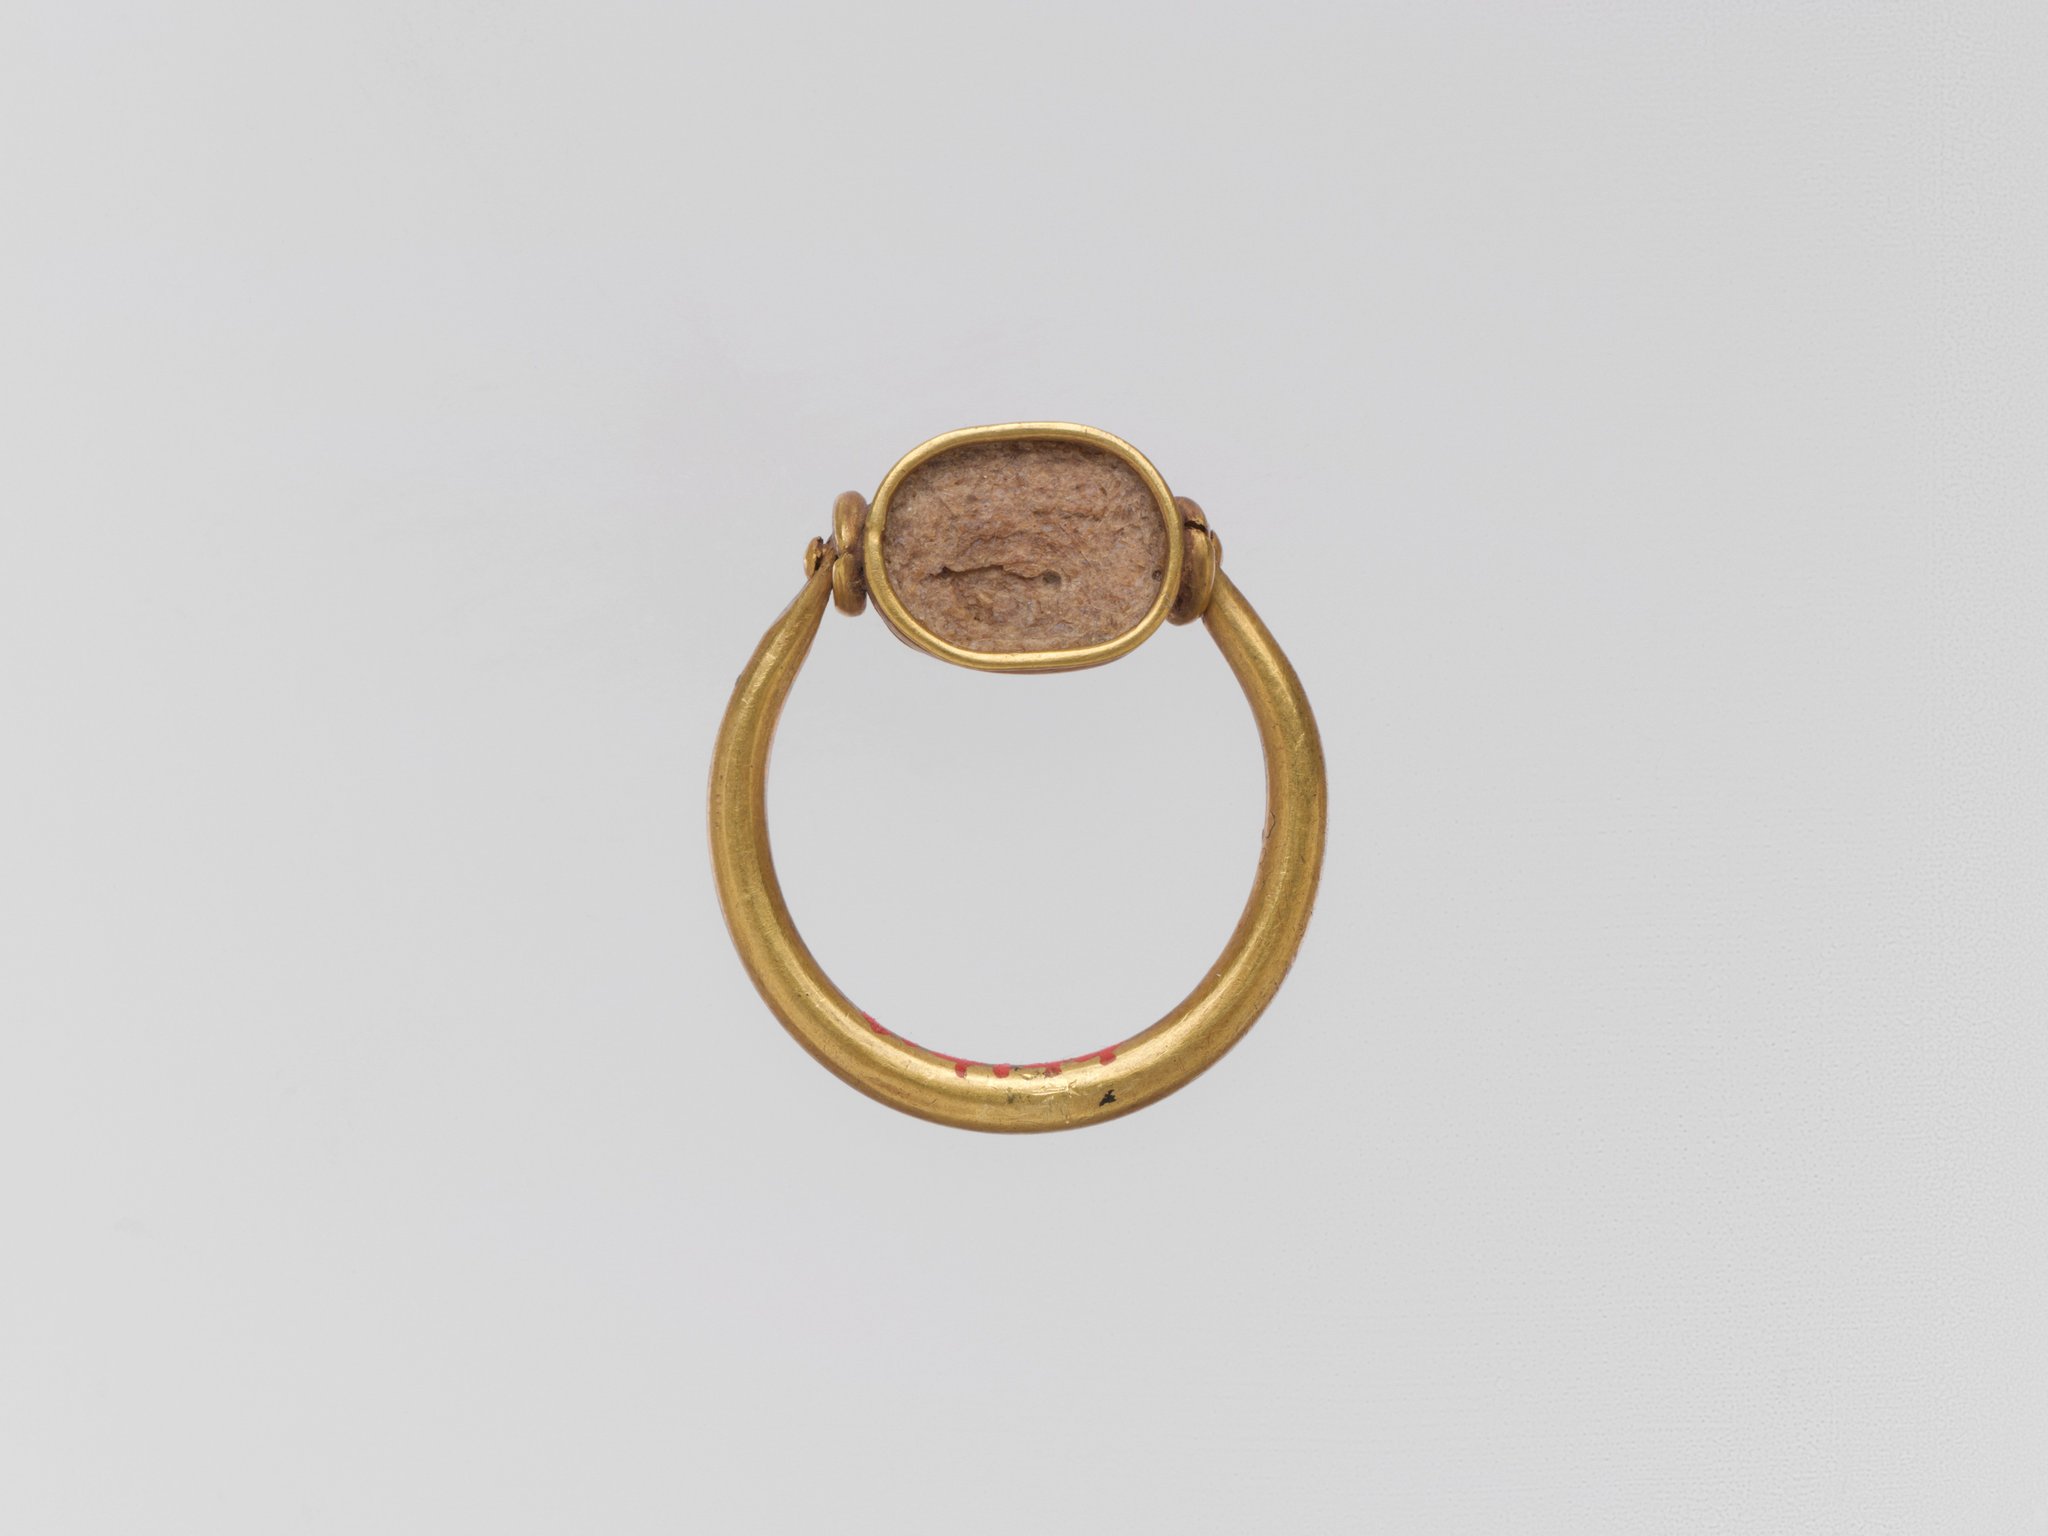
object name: ring with swivel socket and paste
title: Gold ring with glass paste ring stone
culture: cypriot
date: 800-501 BCE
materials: glass, gold, paste